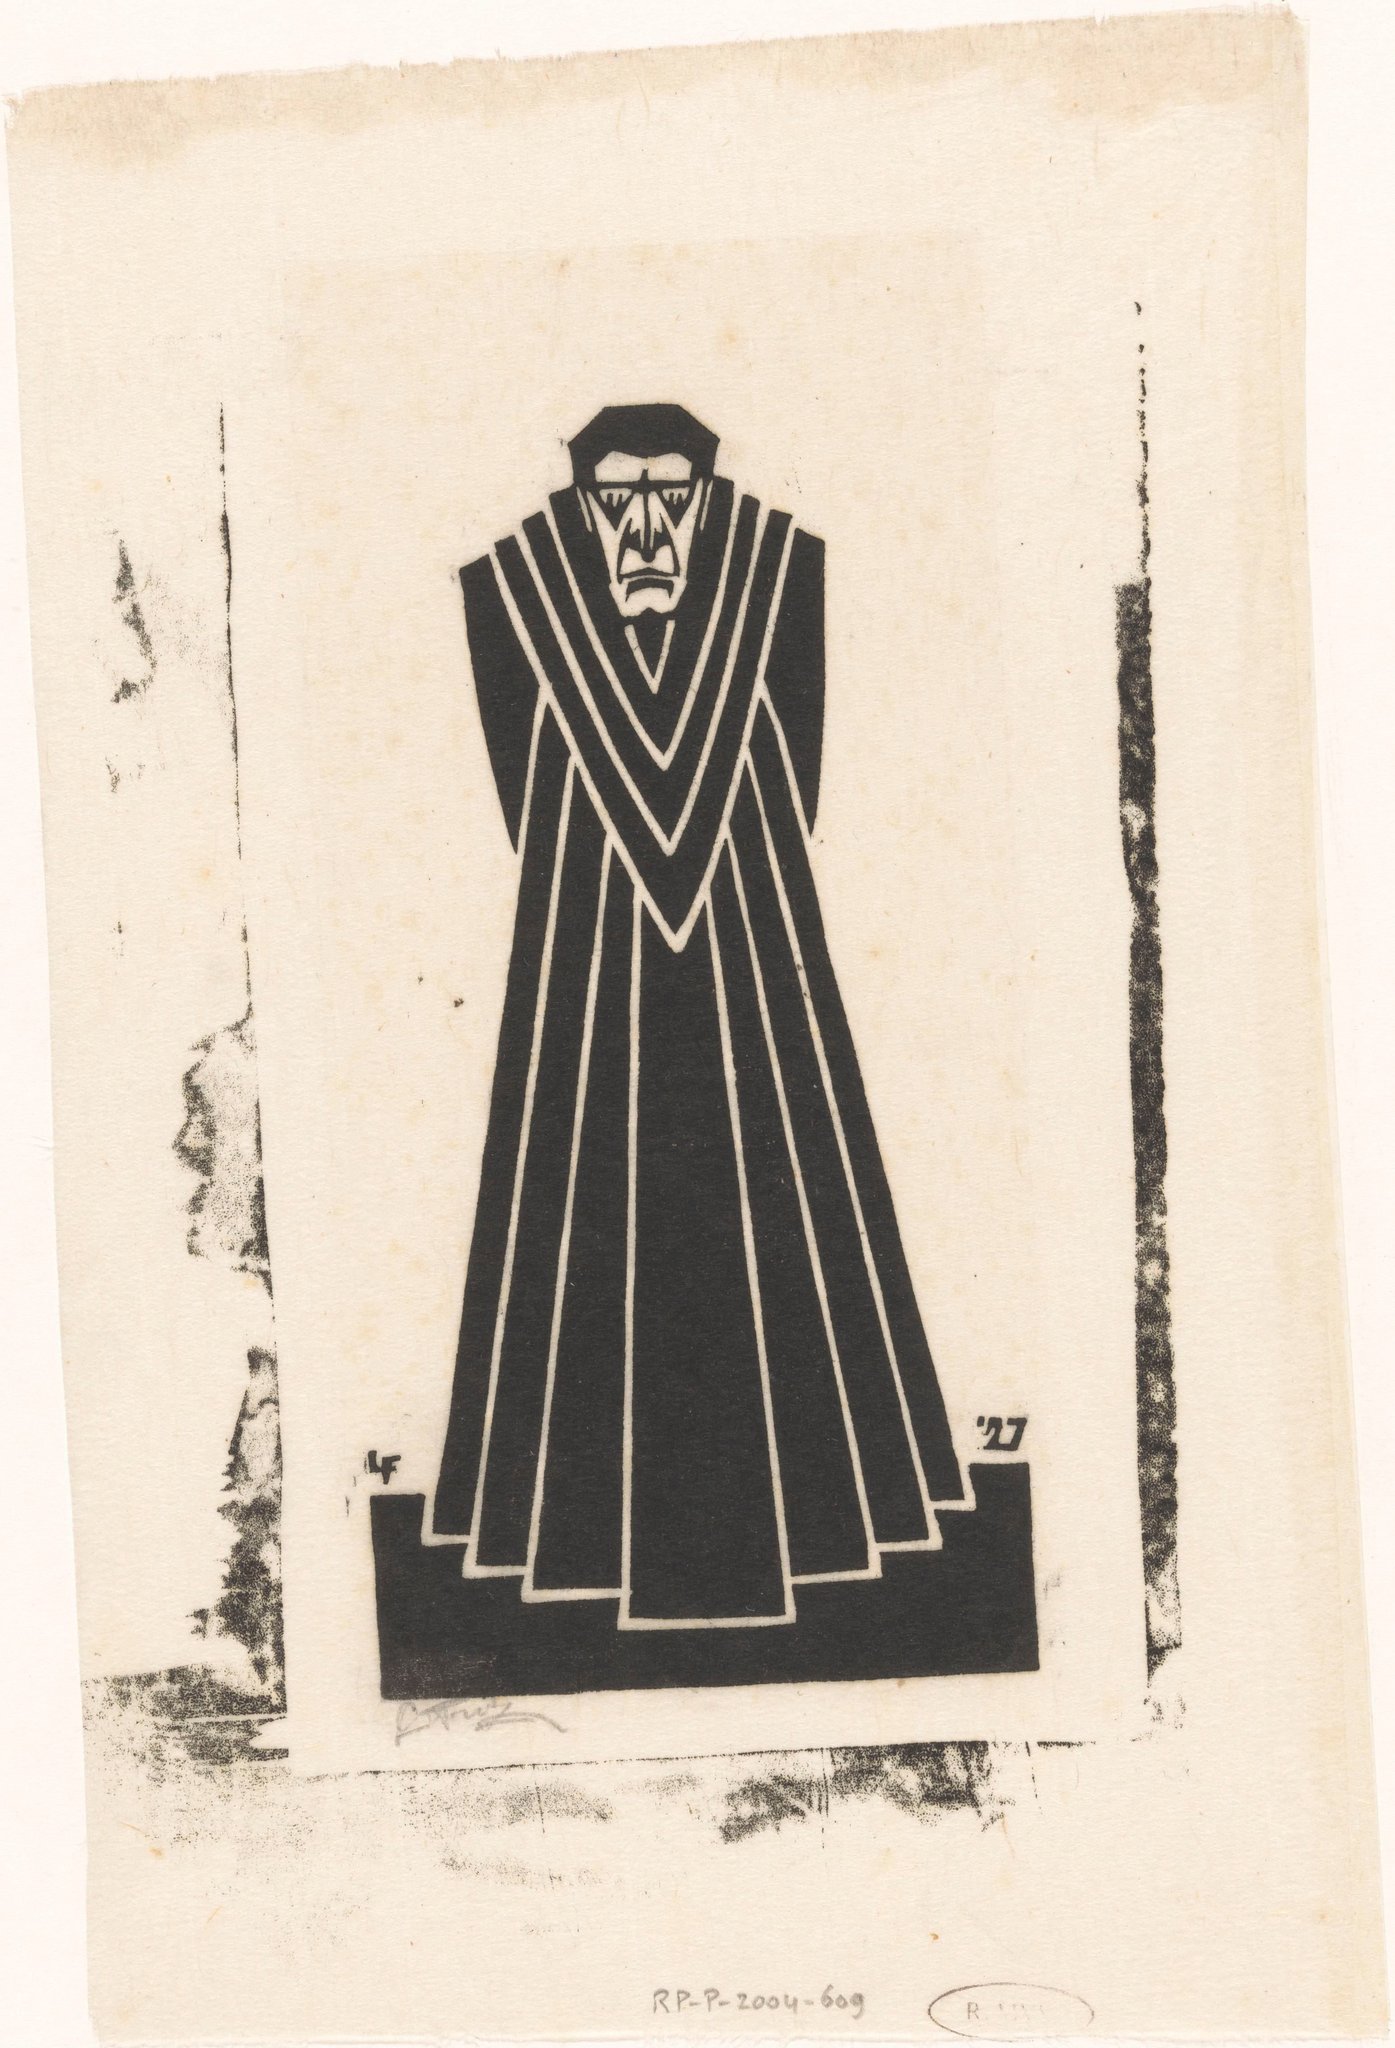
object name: print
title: Priester in een toga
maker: l. fritz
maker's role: print maker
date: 1927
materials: paper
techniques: woodcut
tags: priest (roman catholic)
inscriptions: collector's mark: Lugt 2228